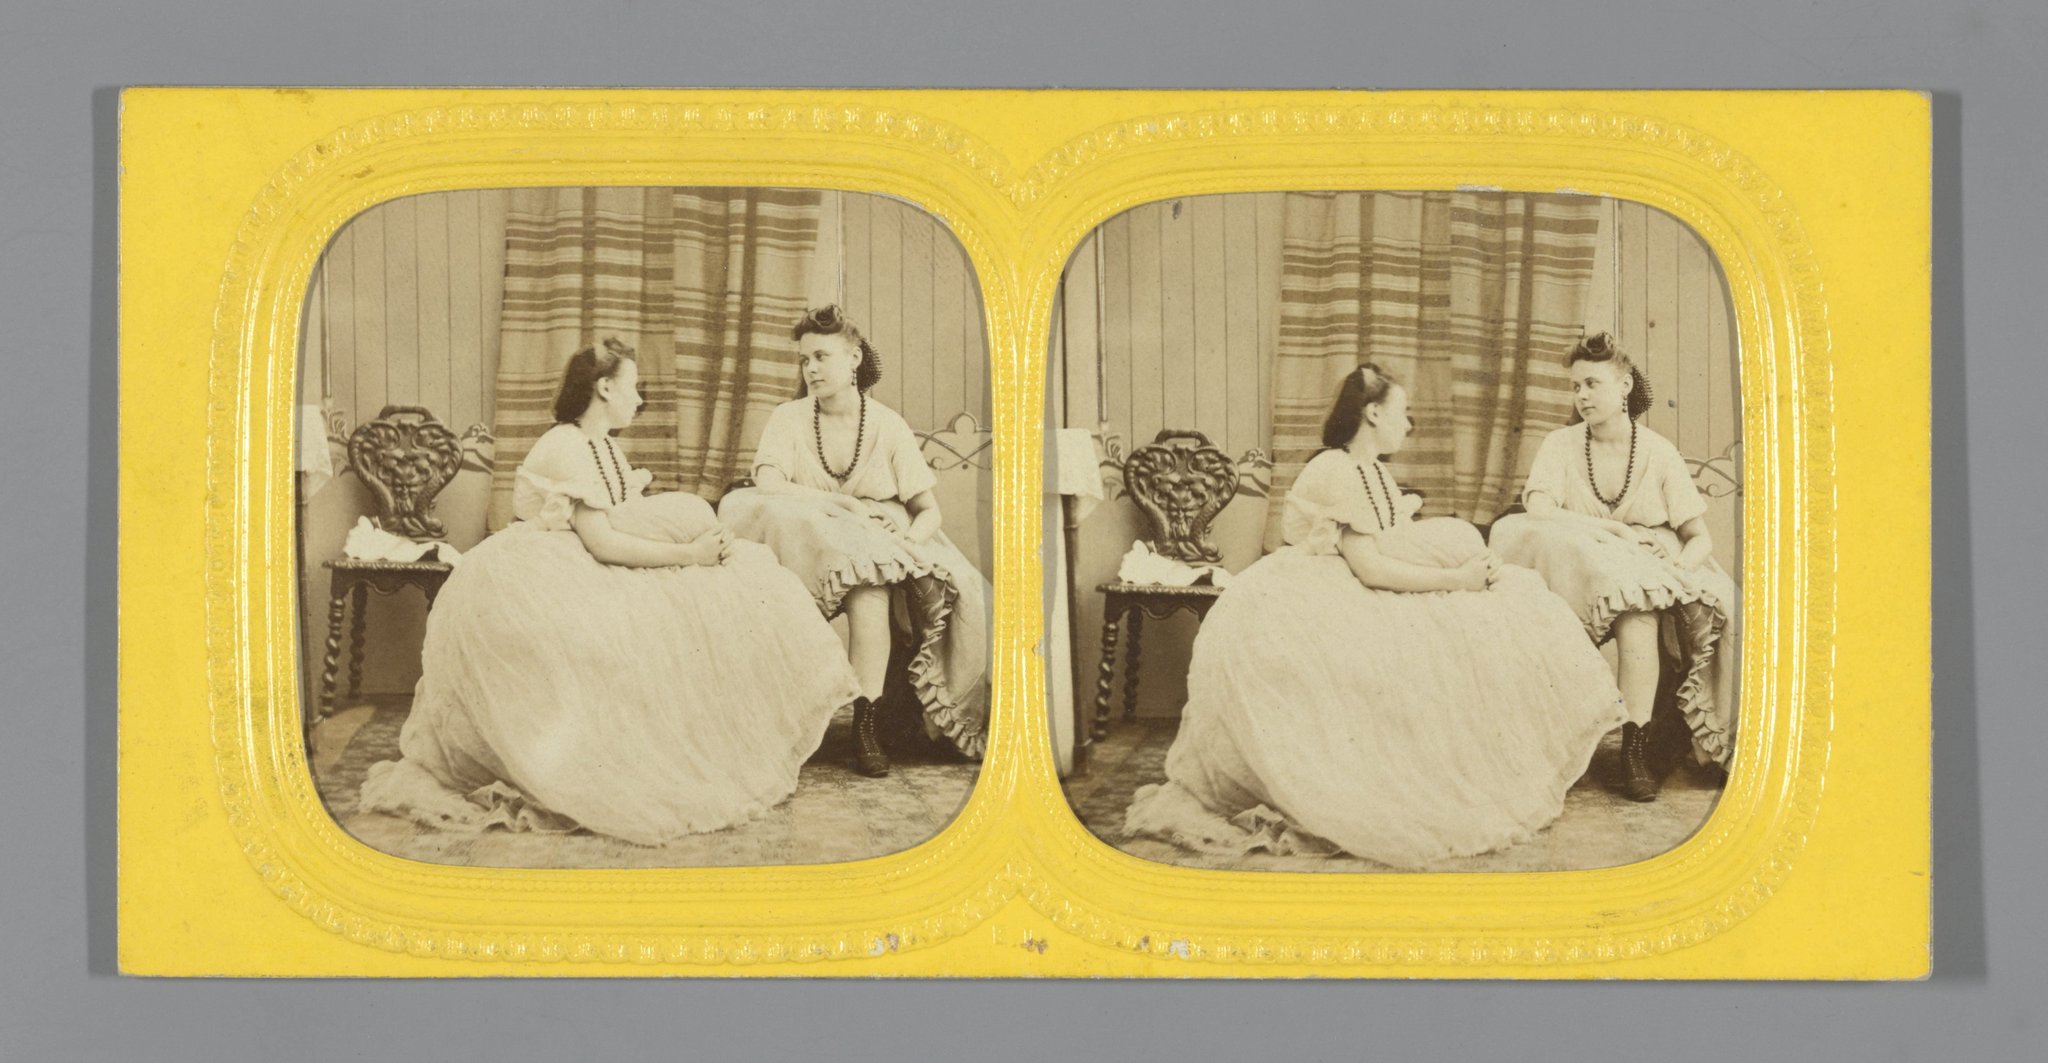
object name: tissue stereograph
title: Twee jonge vrouwen in boudoir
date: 1855-1875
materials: cardboard, paper, photographic support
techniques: albumen print, cutting, hand coloring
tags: boudoir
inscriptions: inscription: ‘50 (...)’